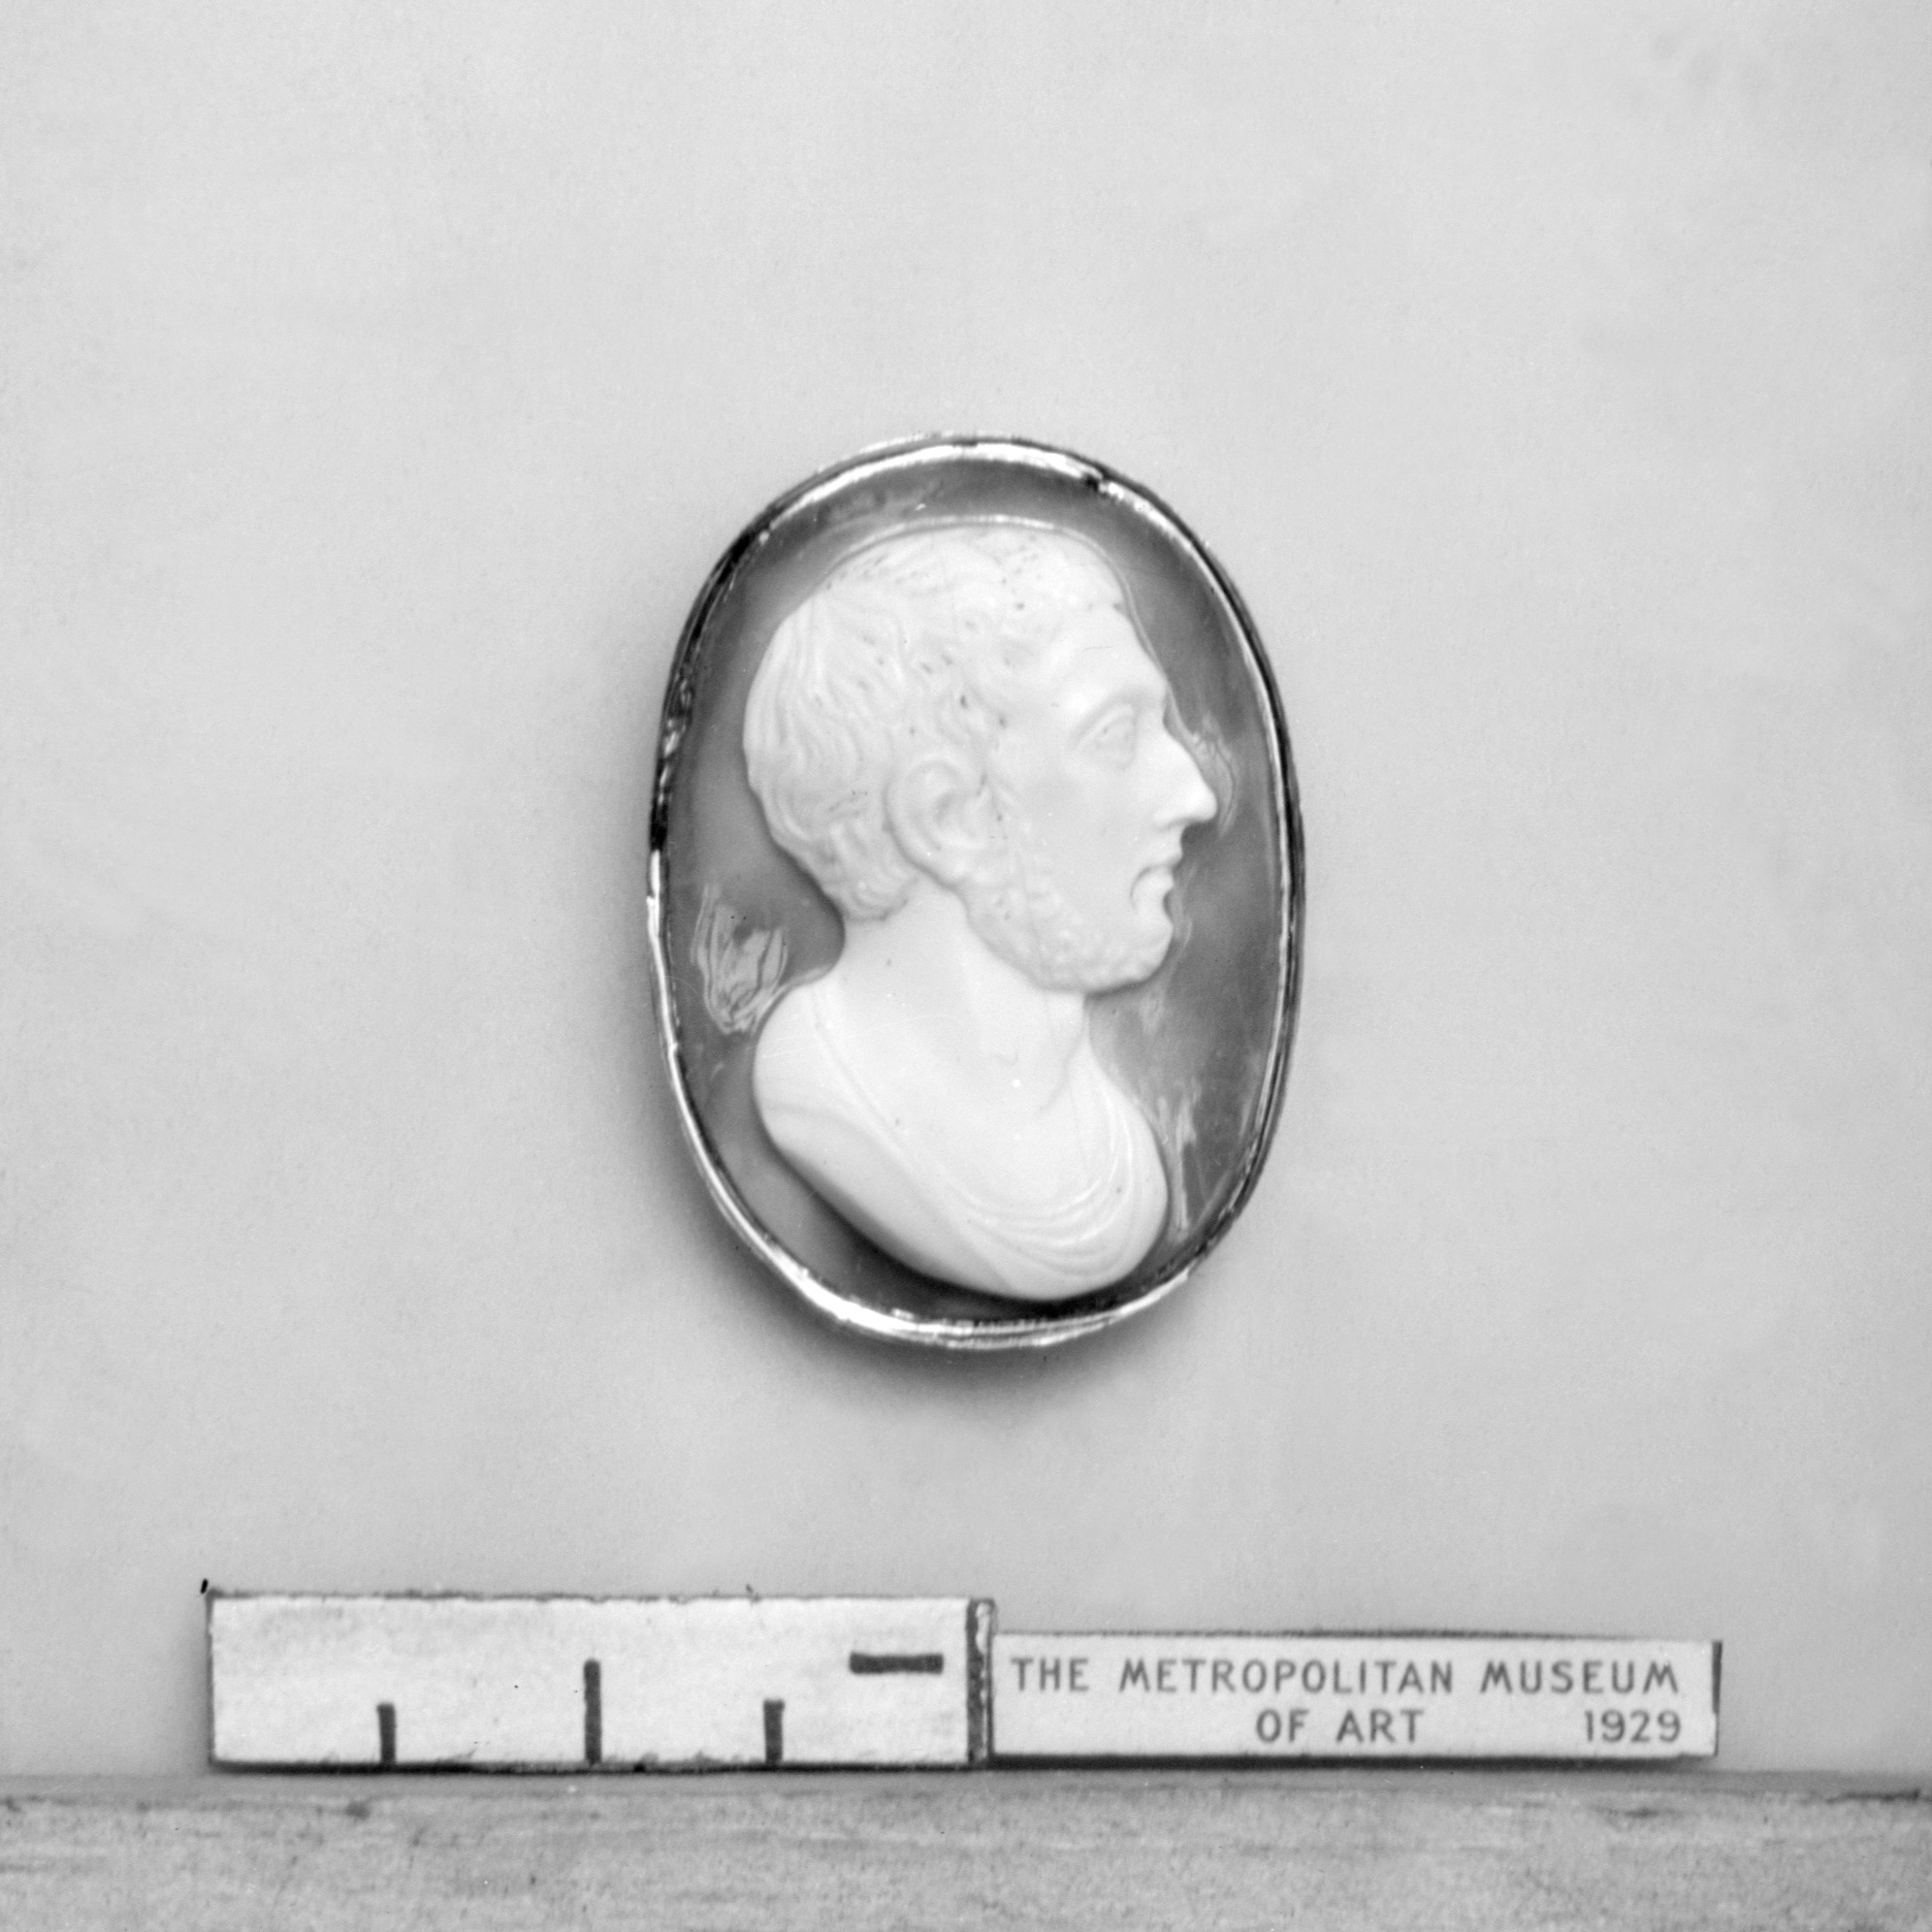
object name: cameo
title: Head of a Roman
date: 1701-1800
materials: gold, gemstone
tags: men,profiles